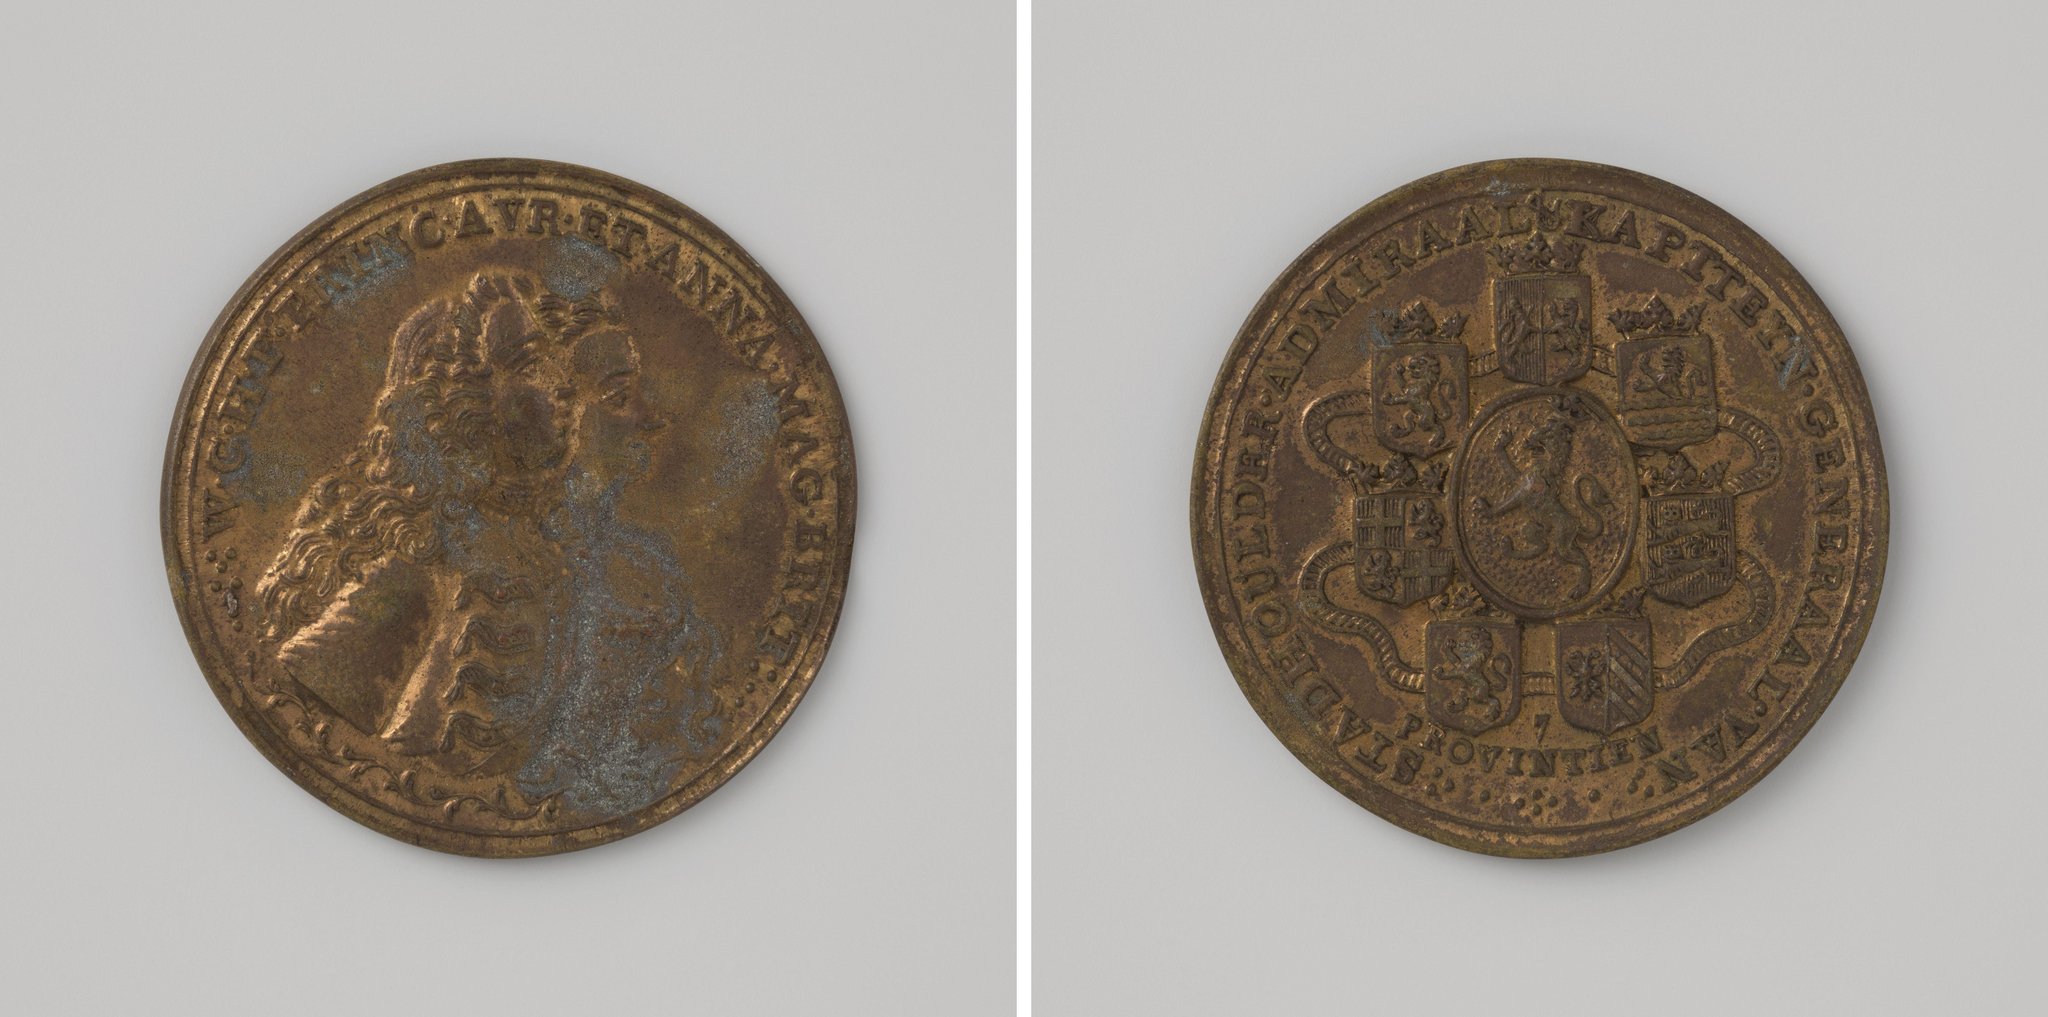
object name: history medal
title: Verheffing van Willem Karel Hendrik Friso tot stadhouder, 1747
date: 1747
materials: brass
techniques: striking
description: Messing penning, op de voorzijde de geconjugeerde borstbeelden van Willem en Anna boven een versiering, met omschrift, op de keerzijde eeen ovaal schild met gekroonde leeuw waromheen zeven provinciale wapenschilden verbonden door een lint, met omschrift